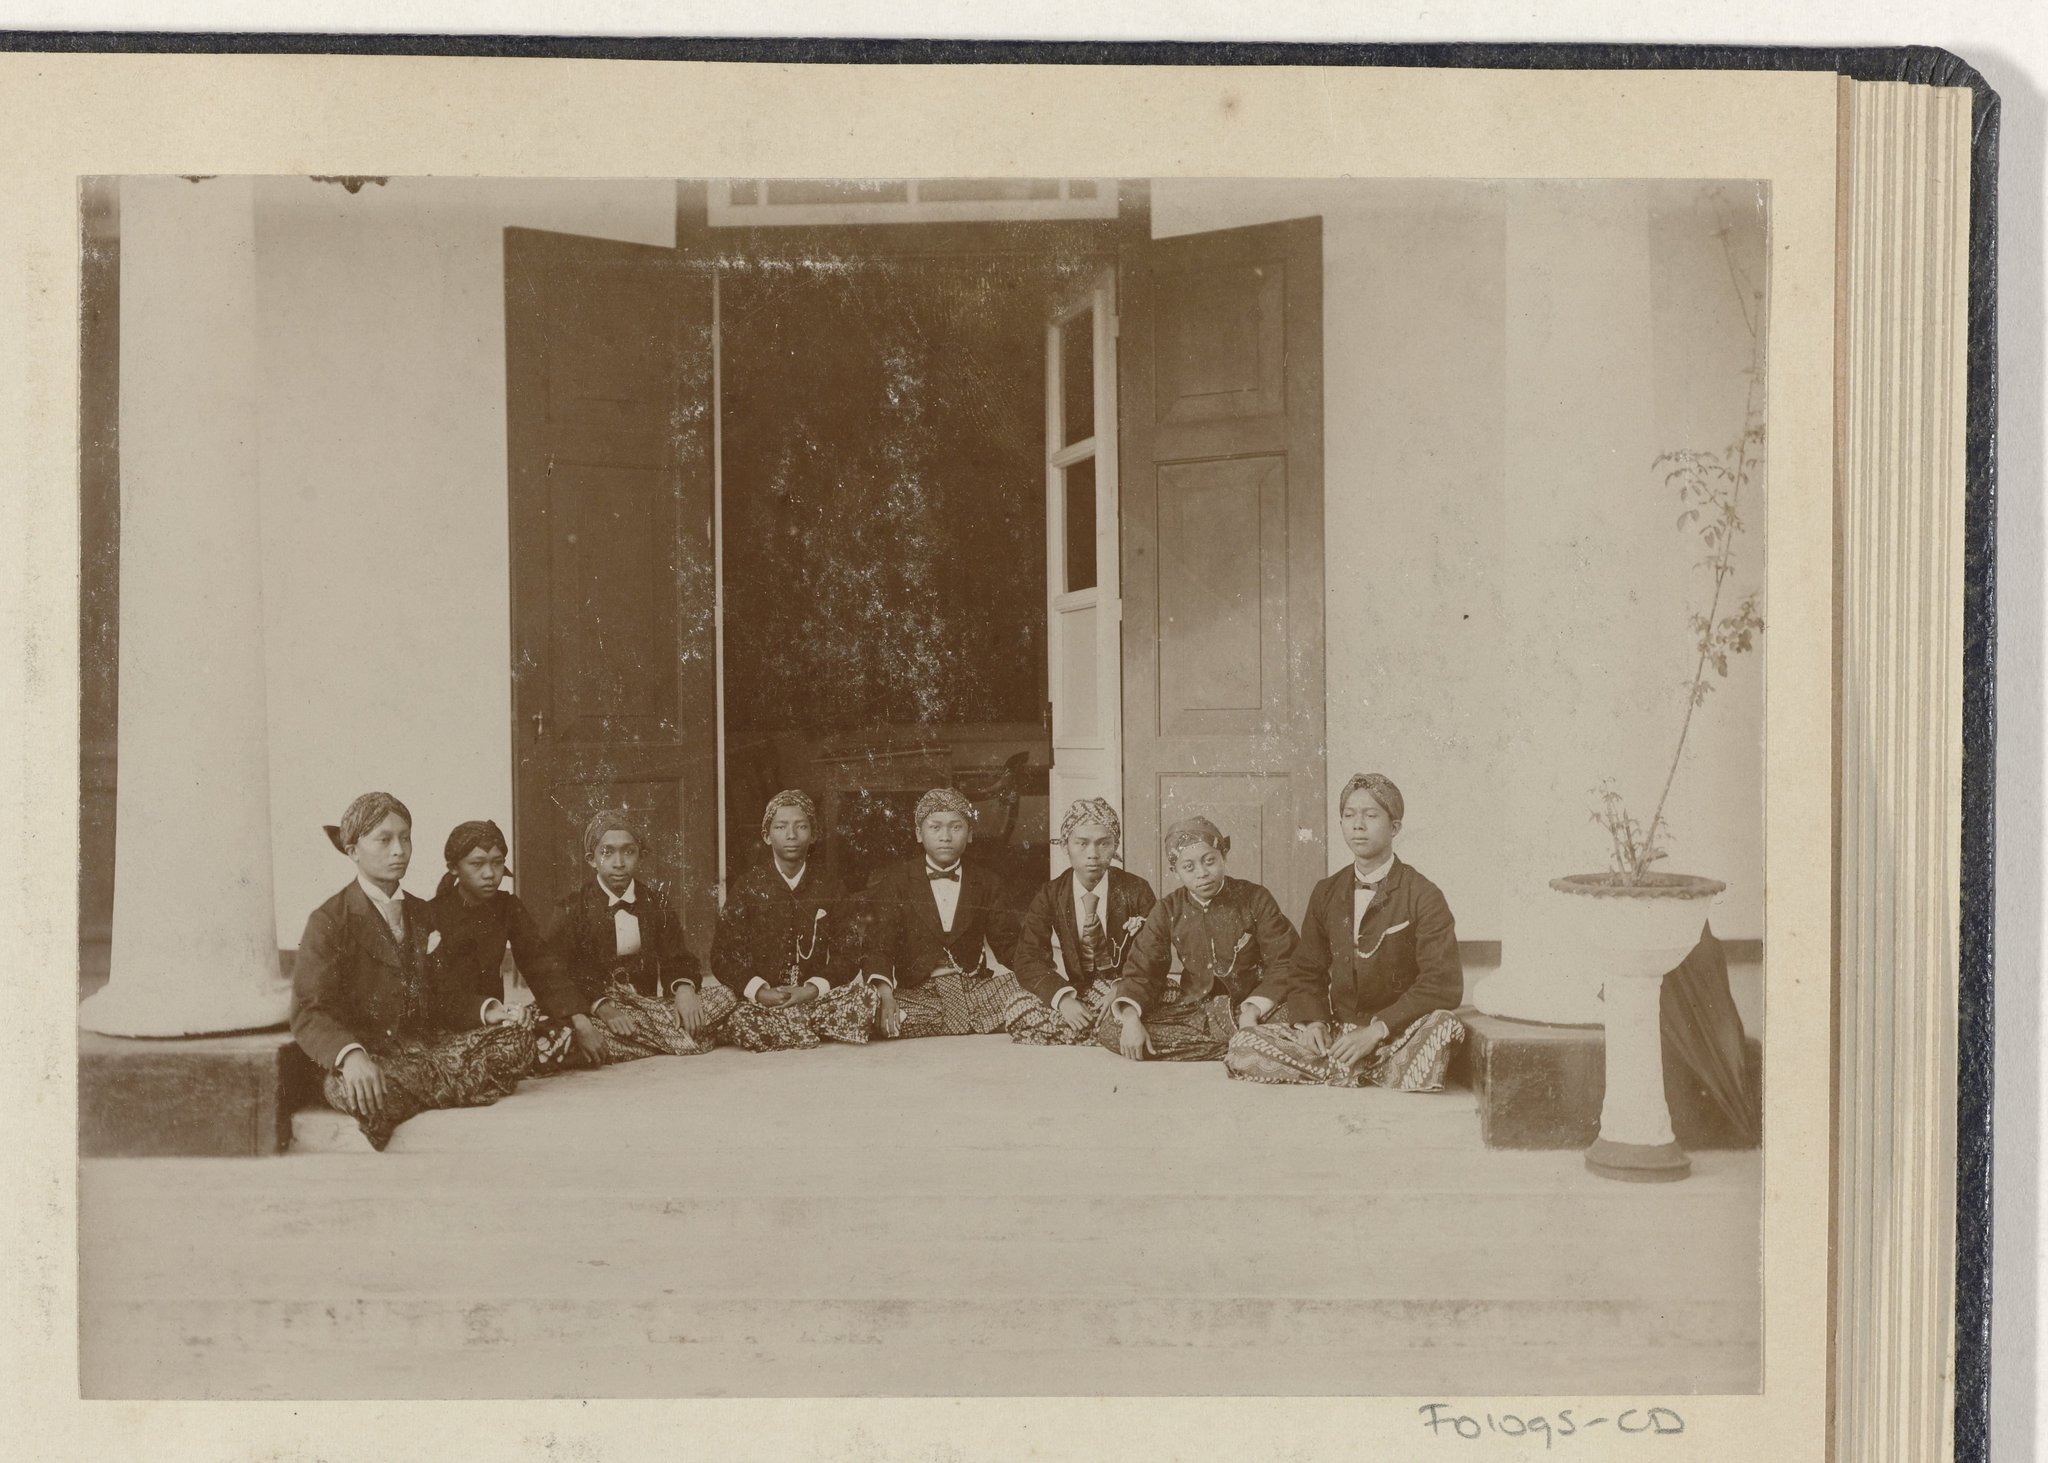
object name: photograph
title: Acht Indische jongemannen gezeten op de vloer bij een ingang in Nederlands-Indië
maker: Anonymous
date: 1895-1905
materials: paper, photographic support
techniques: collodion silver print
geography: dutch east indies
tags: youth, adolescent, dutch east indies, the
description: Onderdeel van Reisalbum met foto's van bezienswaardigheden in Italië, Zwitserland en Nederlands-Indië.